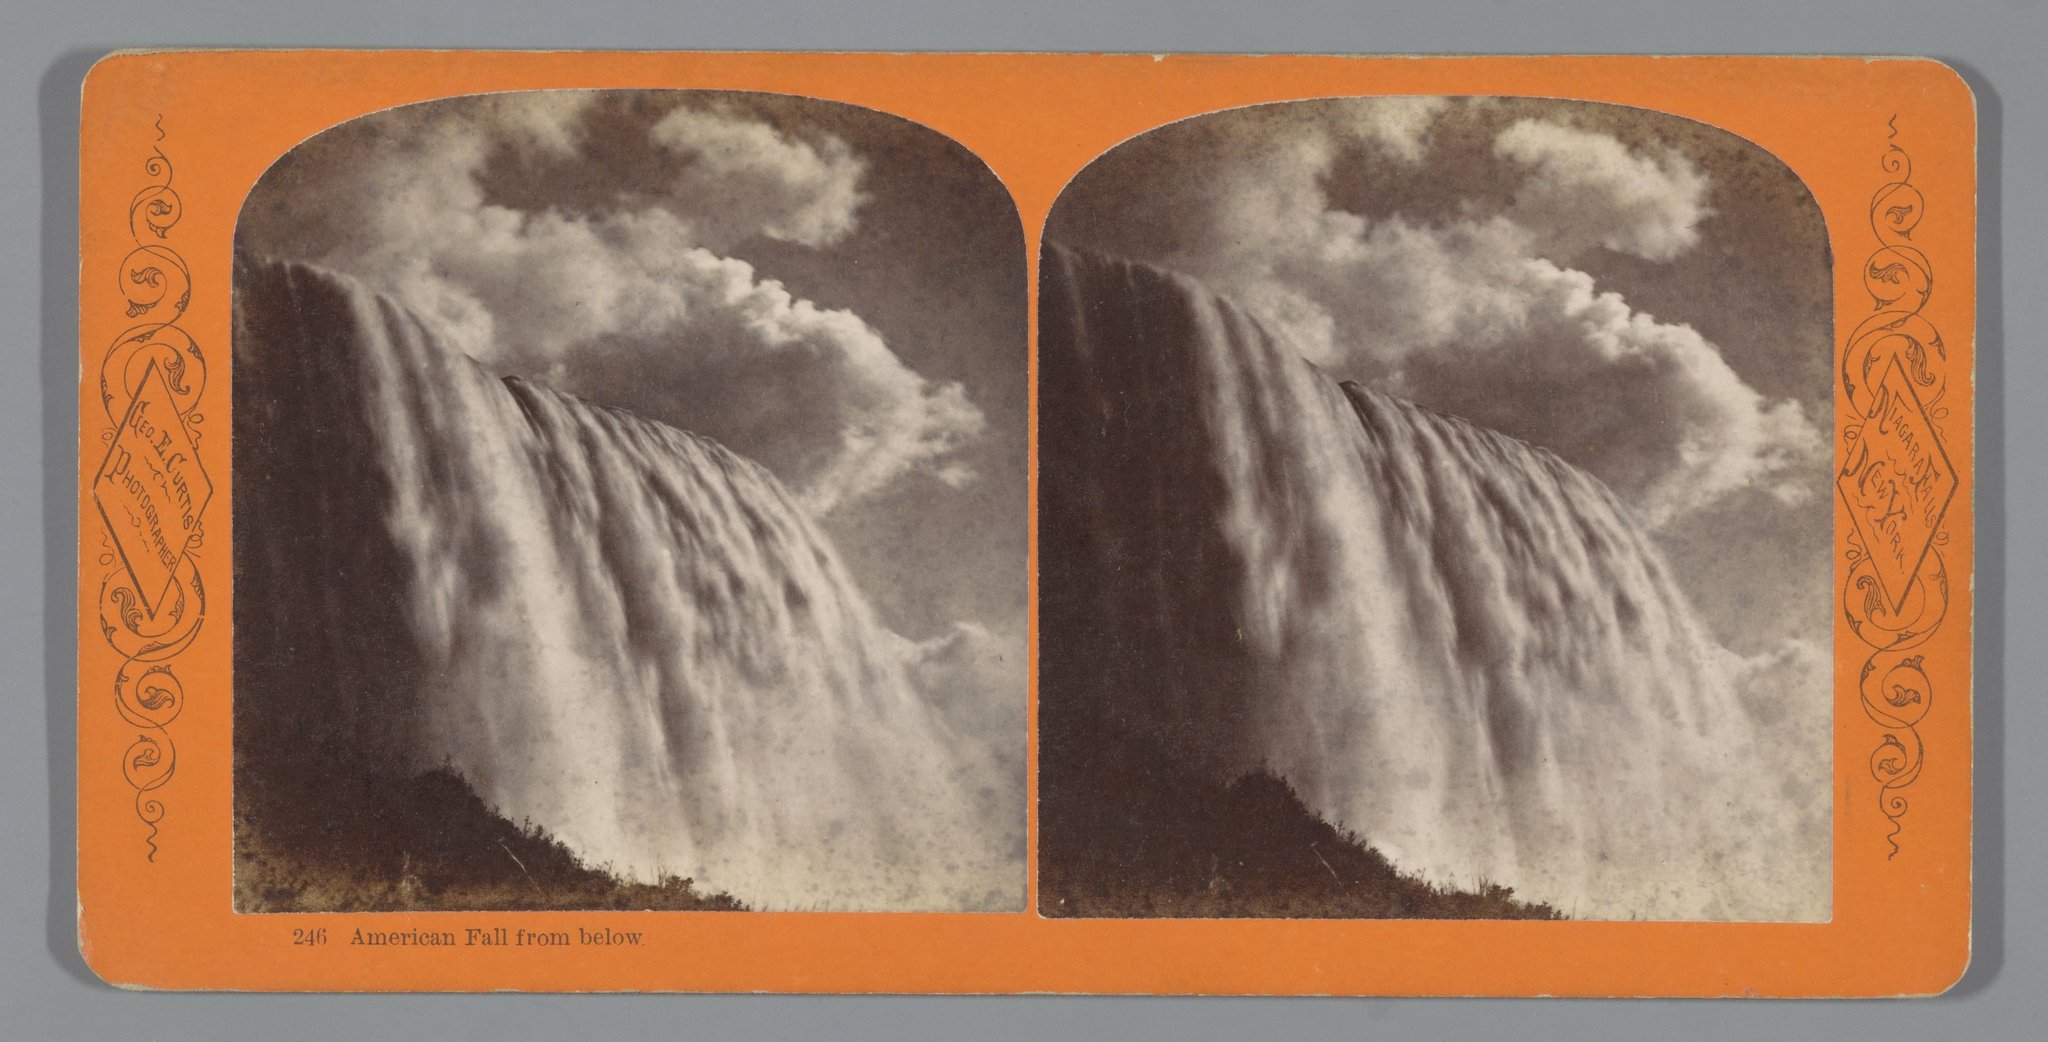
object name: stereograph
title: American Fall from below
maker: george e. curtis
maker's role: fotograaf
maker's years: 1830-1910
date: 1866-1910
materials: cardboard, paper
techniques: albumen print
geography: american falls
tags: waterfall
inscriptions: number: ‘246’